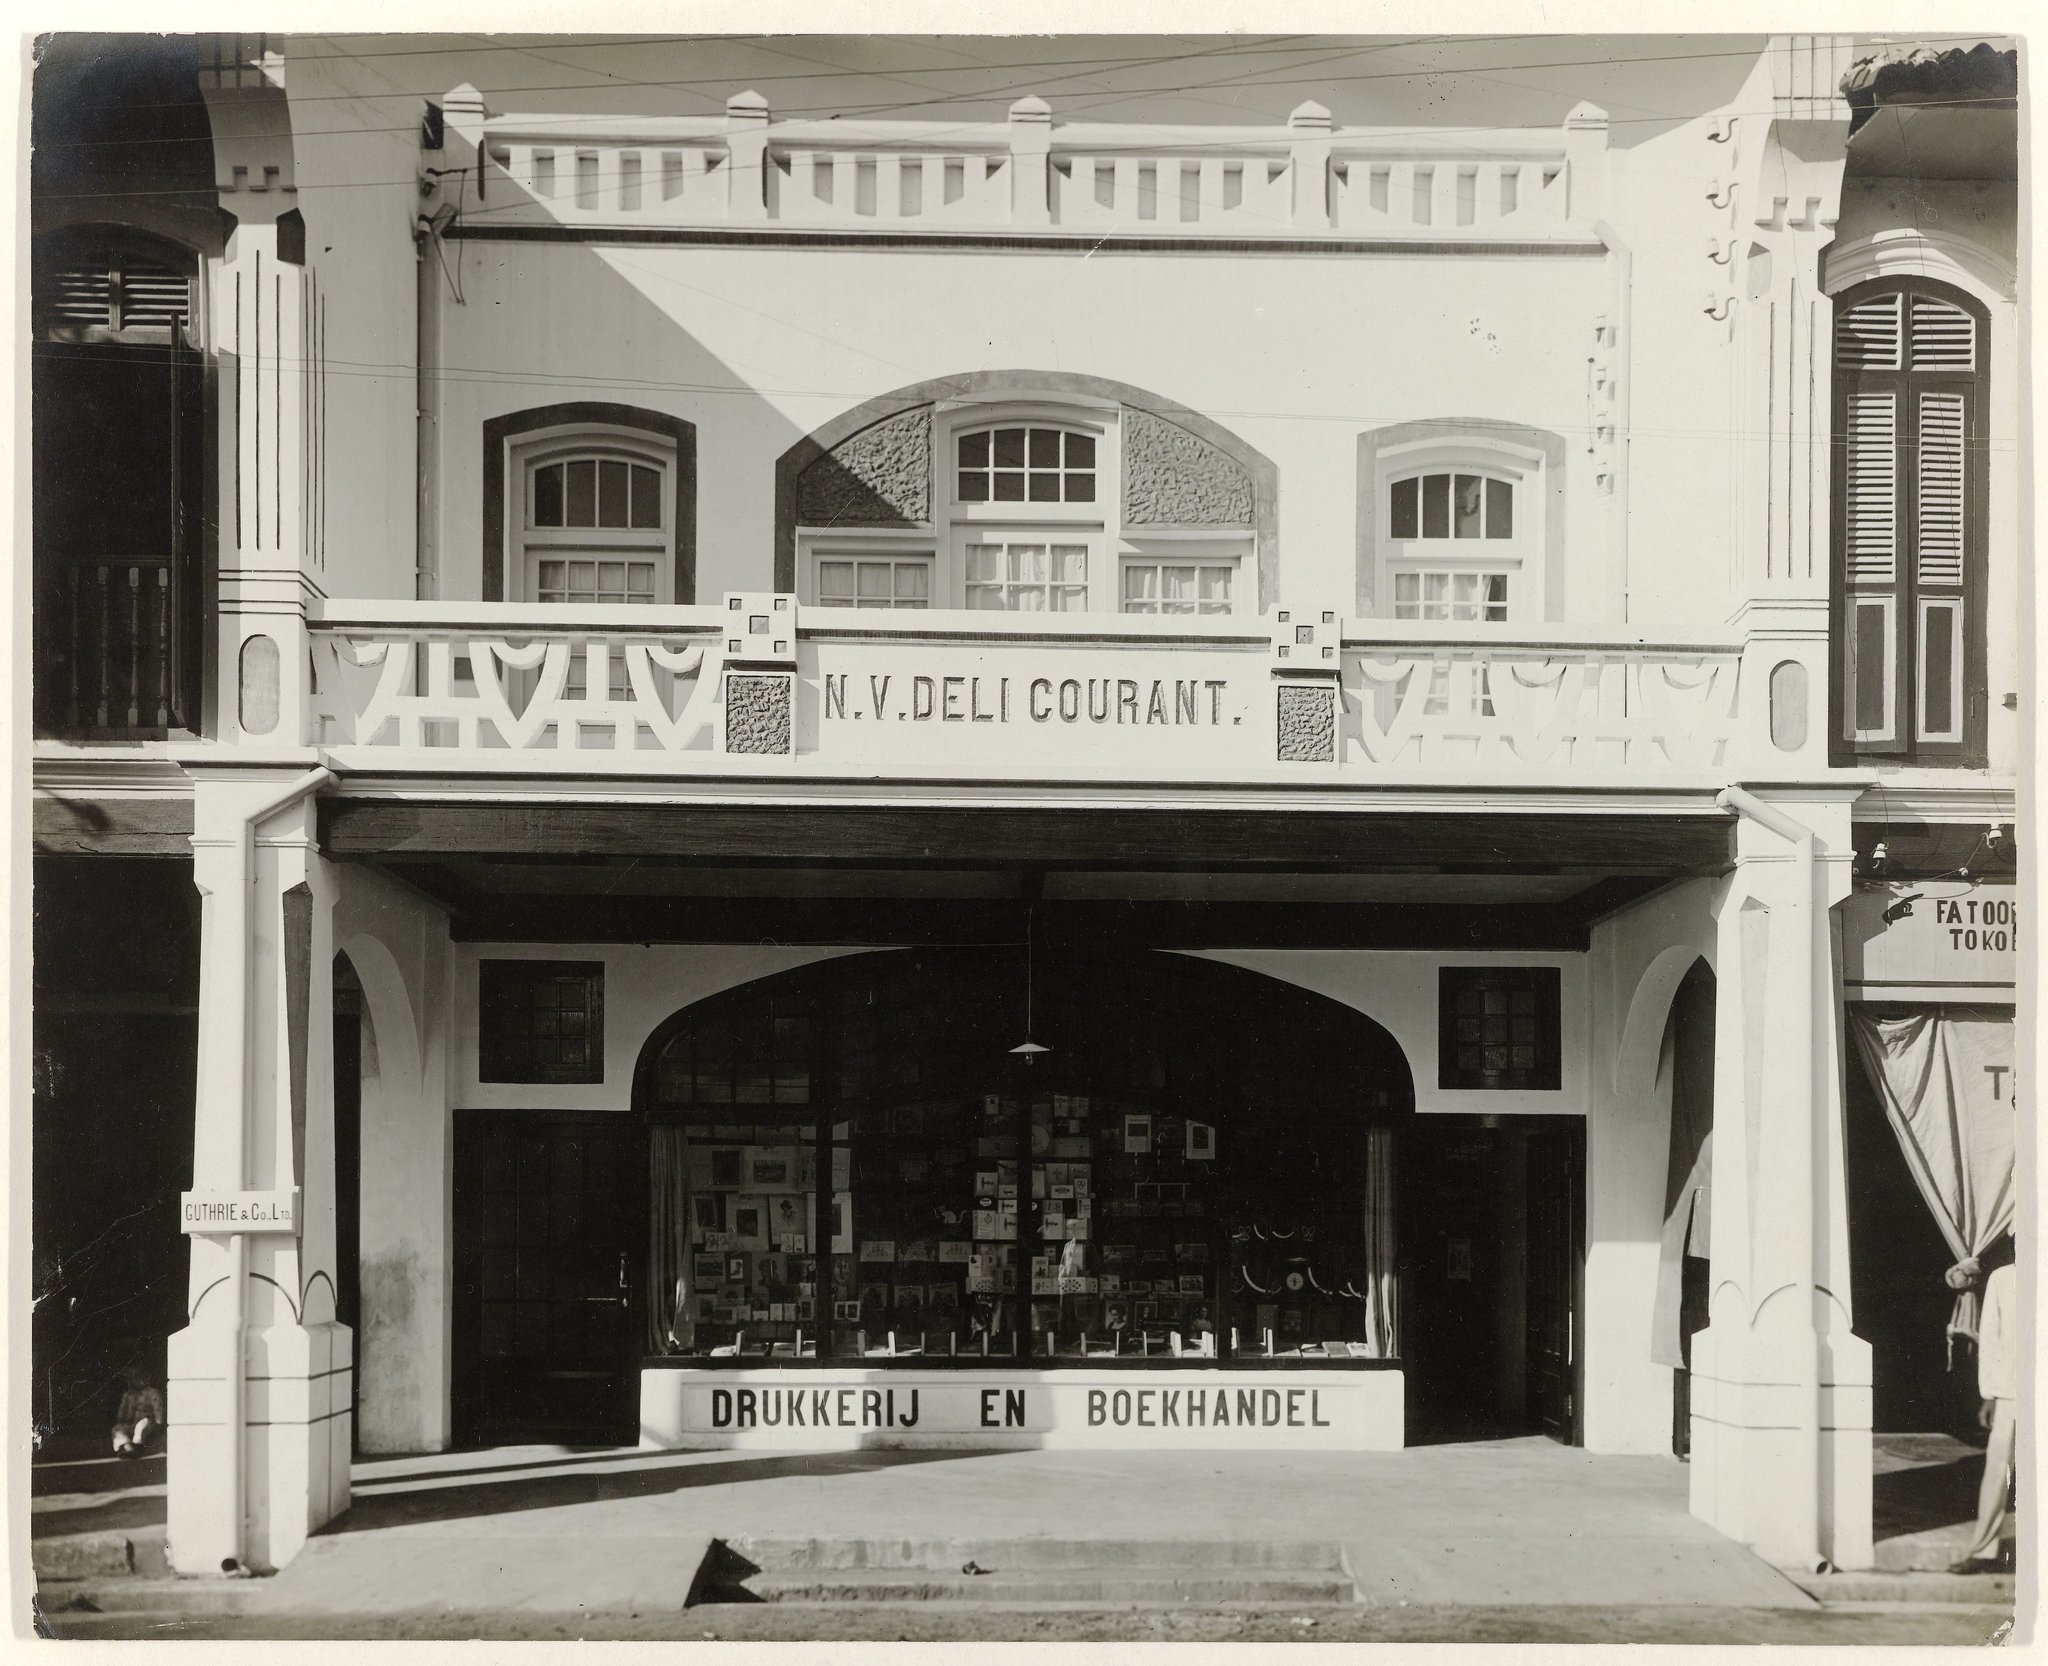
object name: photograph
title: Winkel van de Deli Courant te Medan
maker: asahi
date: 1900-1940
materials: photographic support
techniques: gelatin silver print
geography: medan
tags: dutch east indies, the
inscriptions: company name: ‘Asahi Medan Deli: O.K. van Sumatra’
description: De gevel van de winkel, drukkerij en boekhandel van de Deli Courant te Medan. Onderdeel van een groep van 49 losse zwart-wit foto's van verschillend formaat over de uitgeverij en drukkerij van de krant Deli Courant in Medan in de periode 1885-1947.